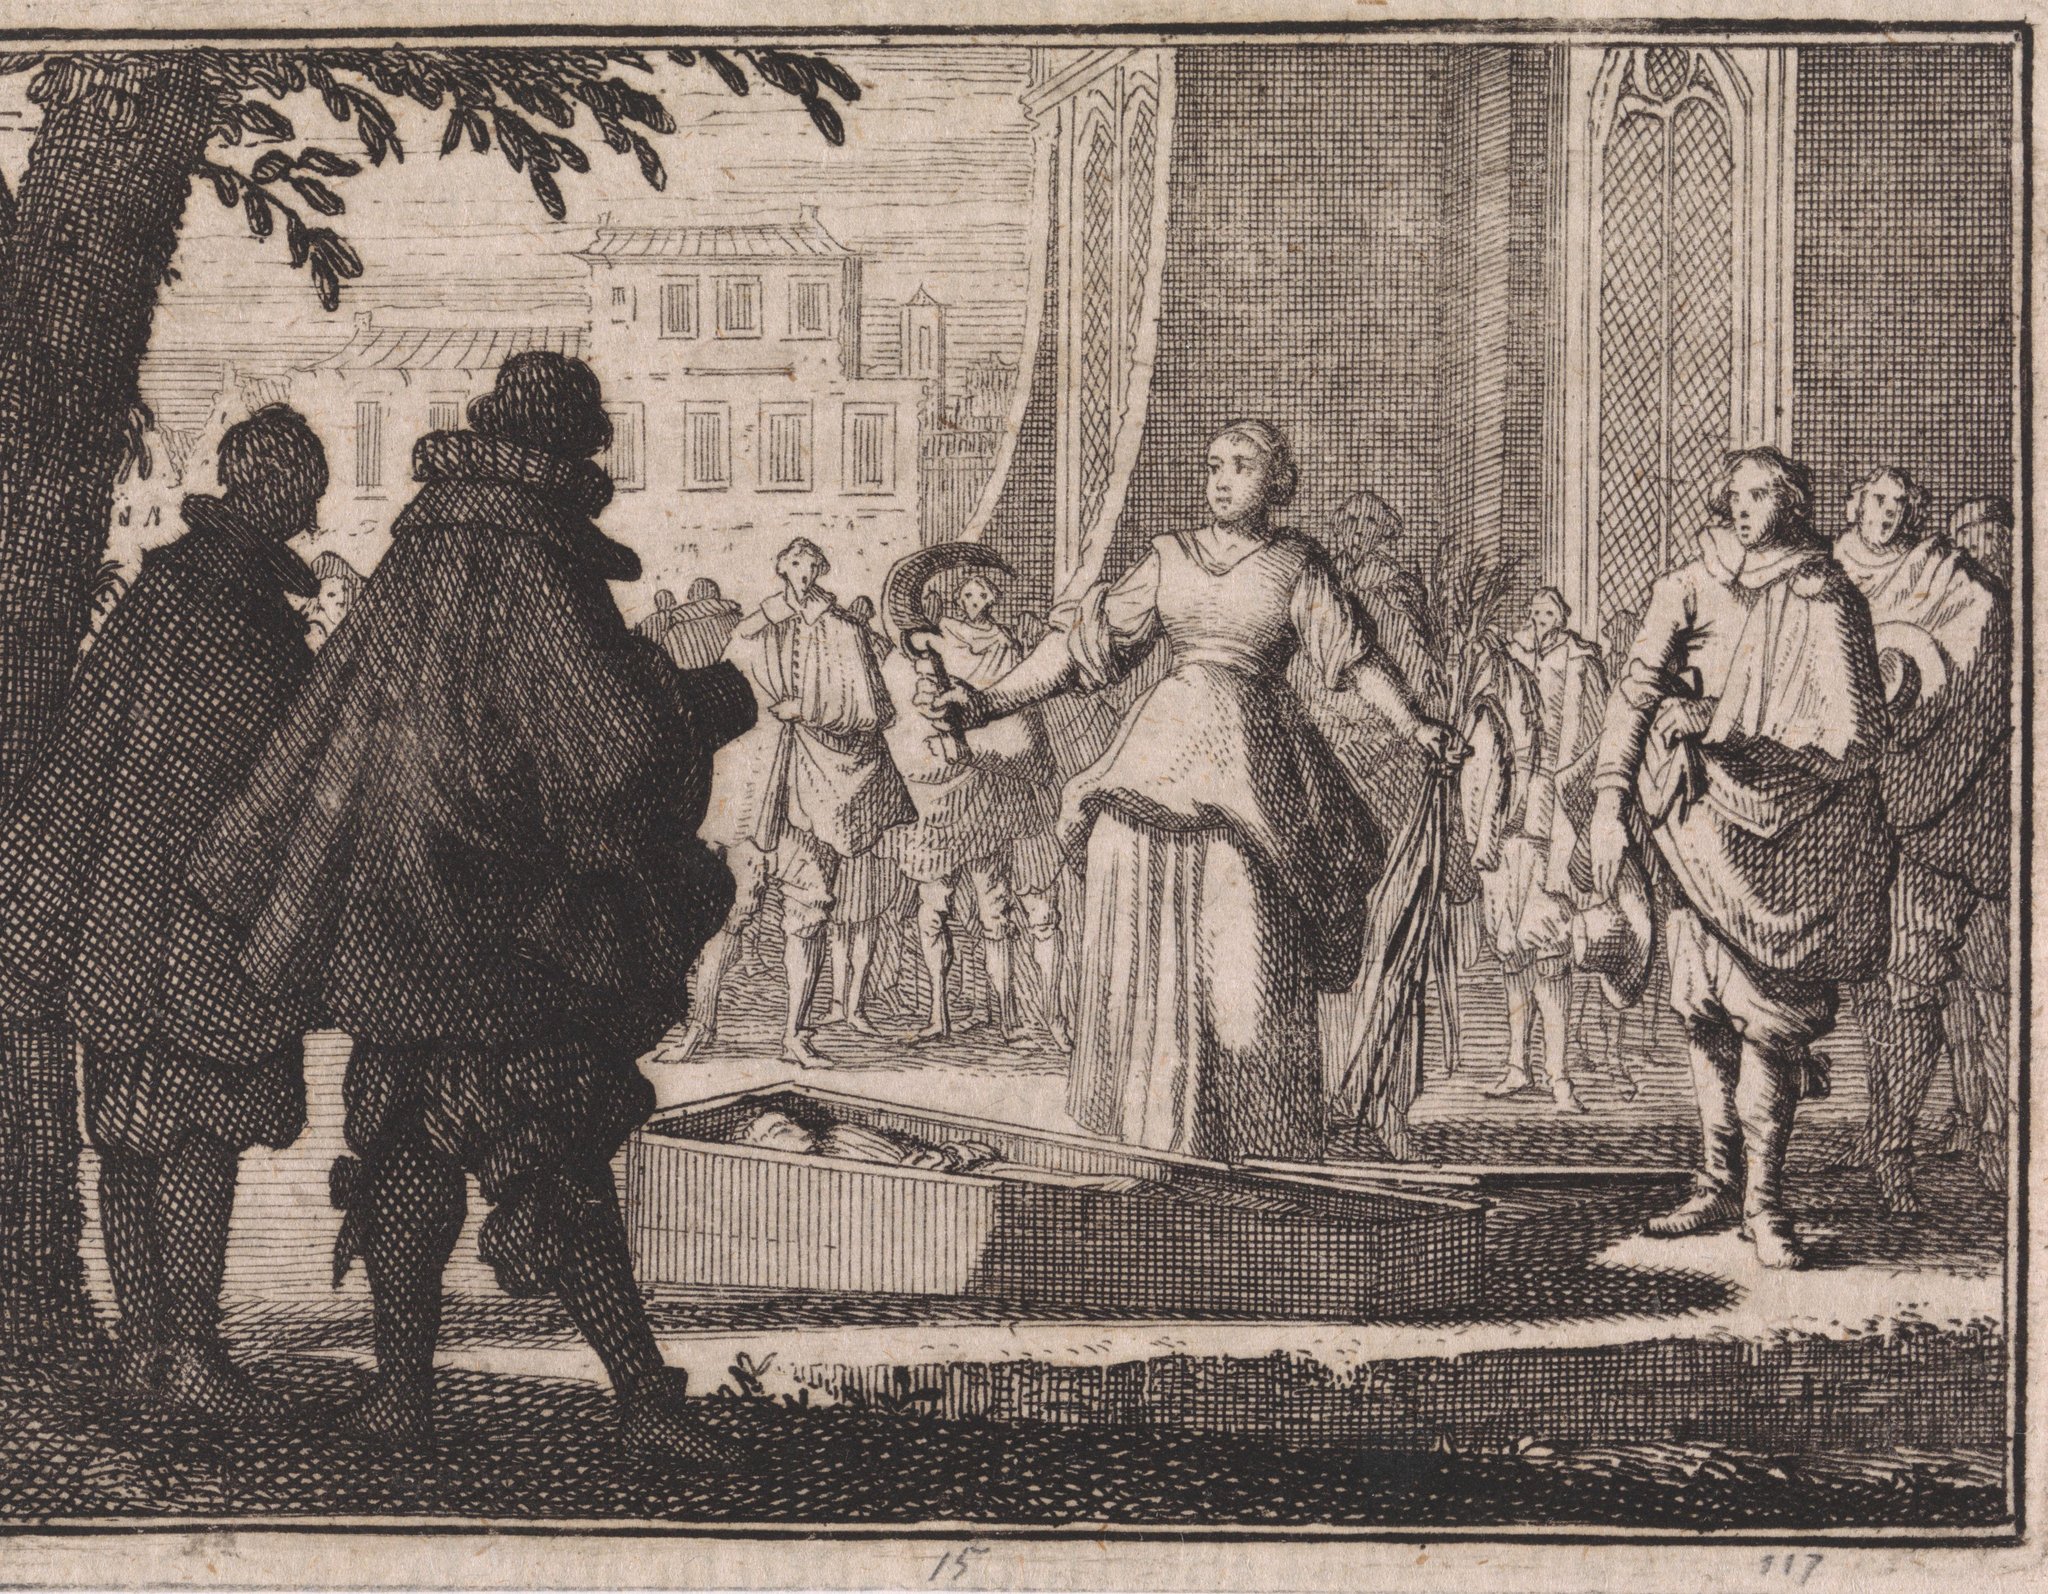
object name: print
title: Boer en boerin tot de doodstraf veroordeeld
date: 1704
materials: paper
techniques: etching, letterpress printing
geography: nuremberg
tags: farmers, death penalty, execution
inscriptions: collector's mark: Lugt 2228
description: Illustratie uit: Abraham a Sancta Clara. Heilsames Gemisch Gemasch, das ist: Allerley seltsame und verwunderliche Geschichten (...). Neurenberg: Christoph Weigel, 1704, p. 117.